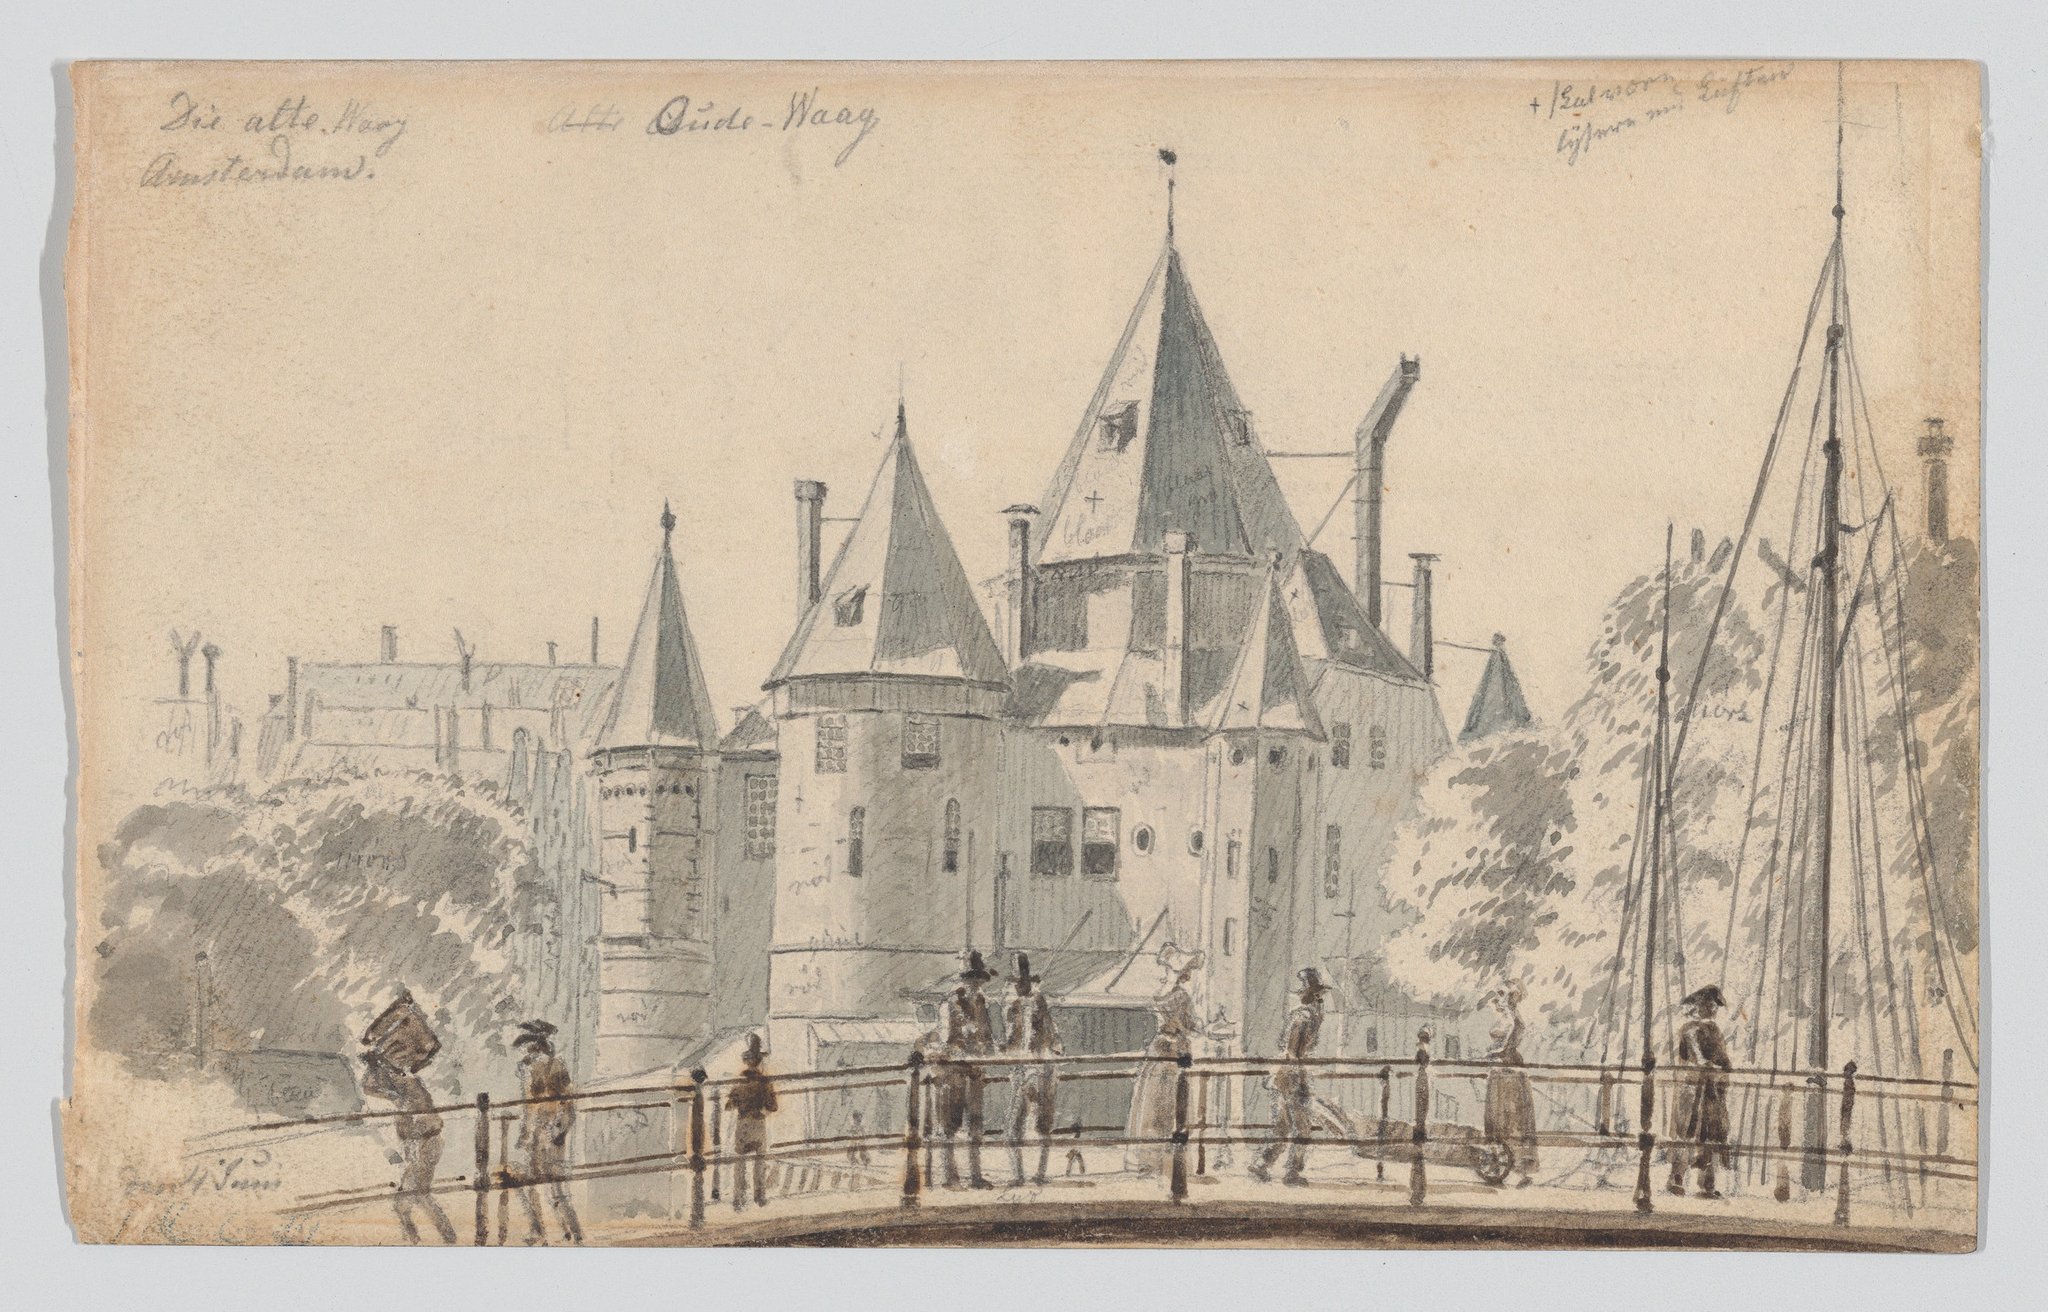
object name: drawing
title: The Oude Waag in Amsterdam Seen from the North-East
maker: martinus rørbye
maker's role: artist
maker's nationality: danish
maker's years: 1803-1848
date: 1834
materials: graphite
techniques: wash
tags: buildings,bridges,amsterdam